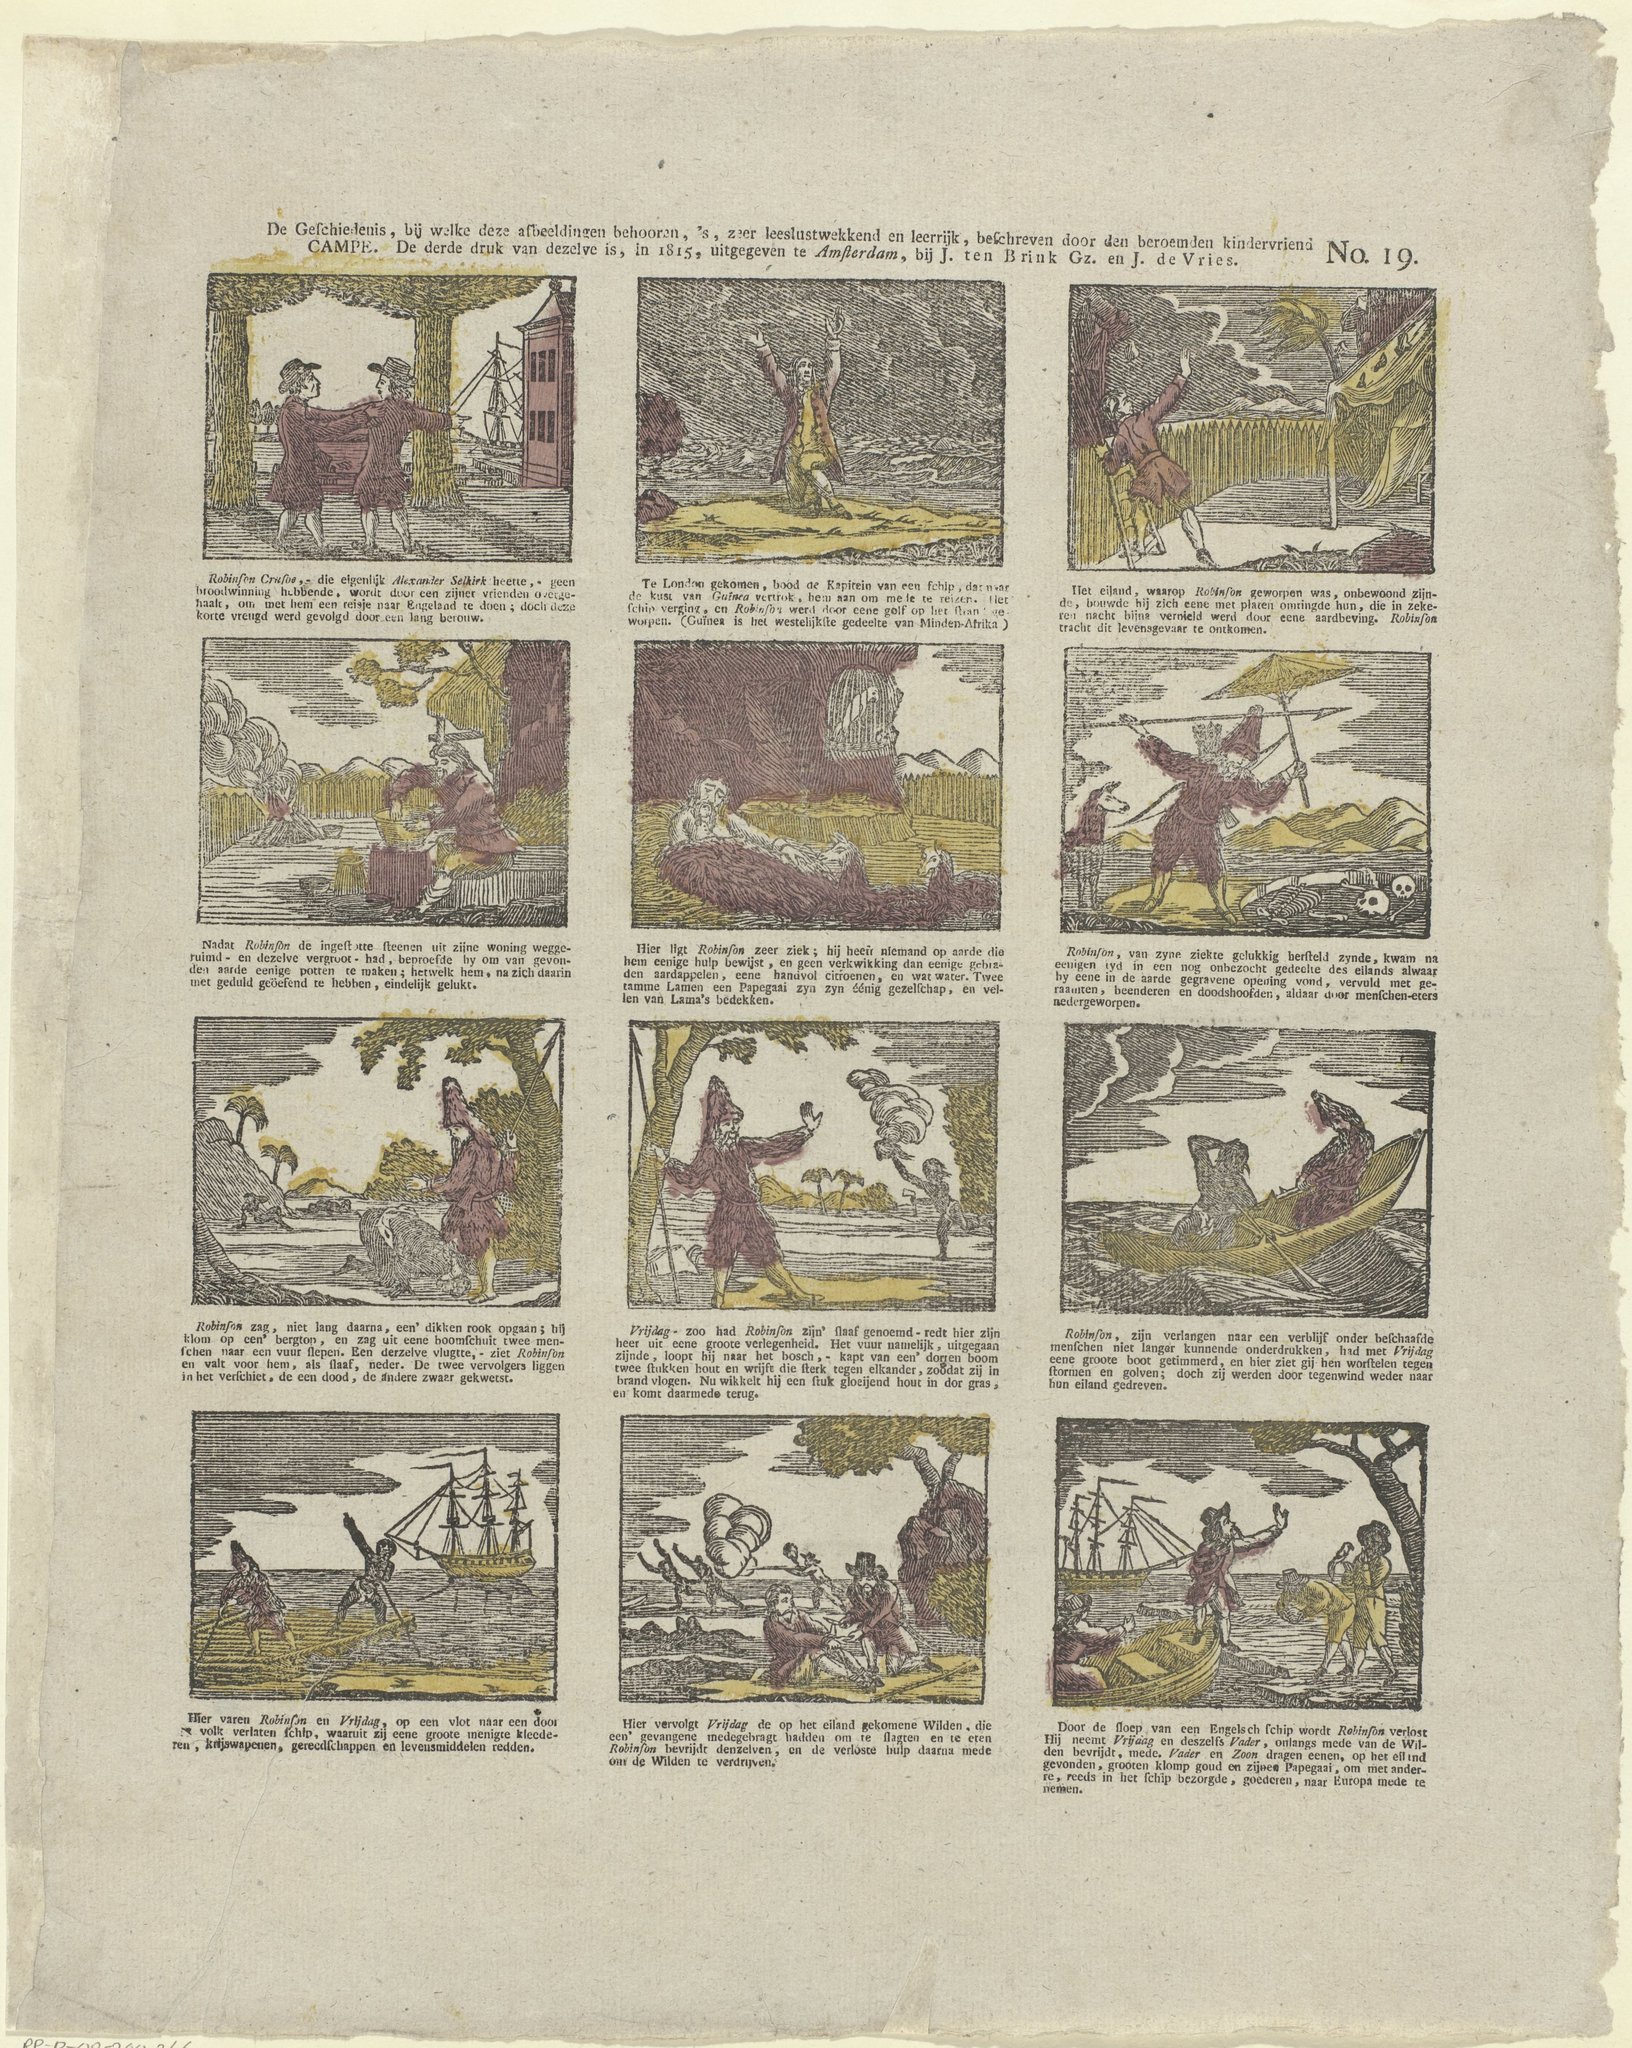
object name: popular print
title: De geschiedenis, bij welke deze afbeeldingen behooren, is, zeer leeslustwekkend en leerrijk, beschreven door den beroemden kindervriend / Camp (...)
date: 1820-1838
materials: paper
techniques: colour, letterpress printing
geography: rotterdam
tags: (scenes from) specific works of literature: defoe, robinson crusoe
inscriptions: collector's mark: Lugt 2760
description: Blad met 12 voorstellingen uit het verhaal van Robinson Crusoe die strandt op een eiland. Onder elke afbeelding een onderschrift. Genummerd rechtsboven: No. 19.